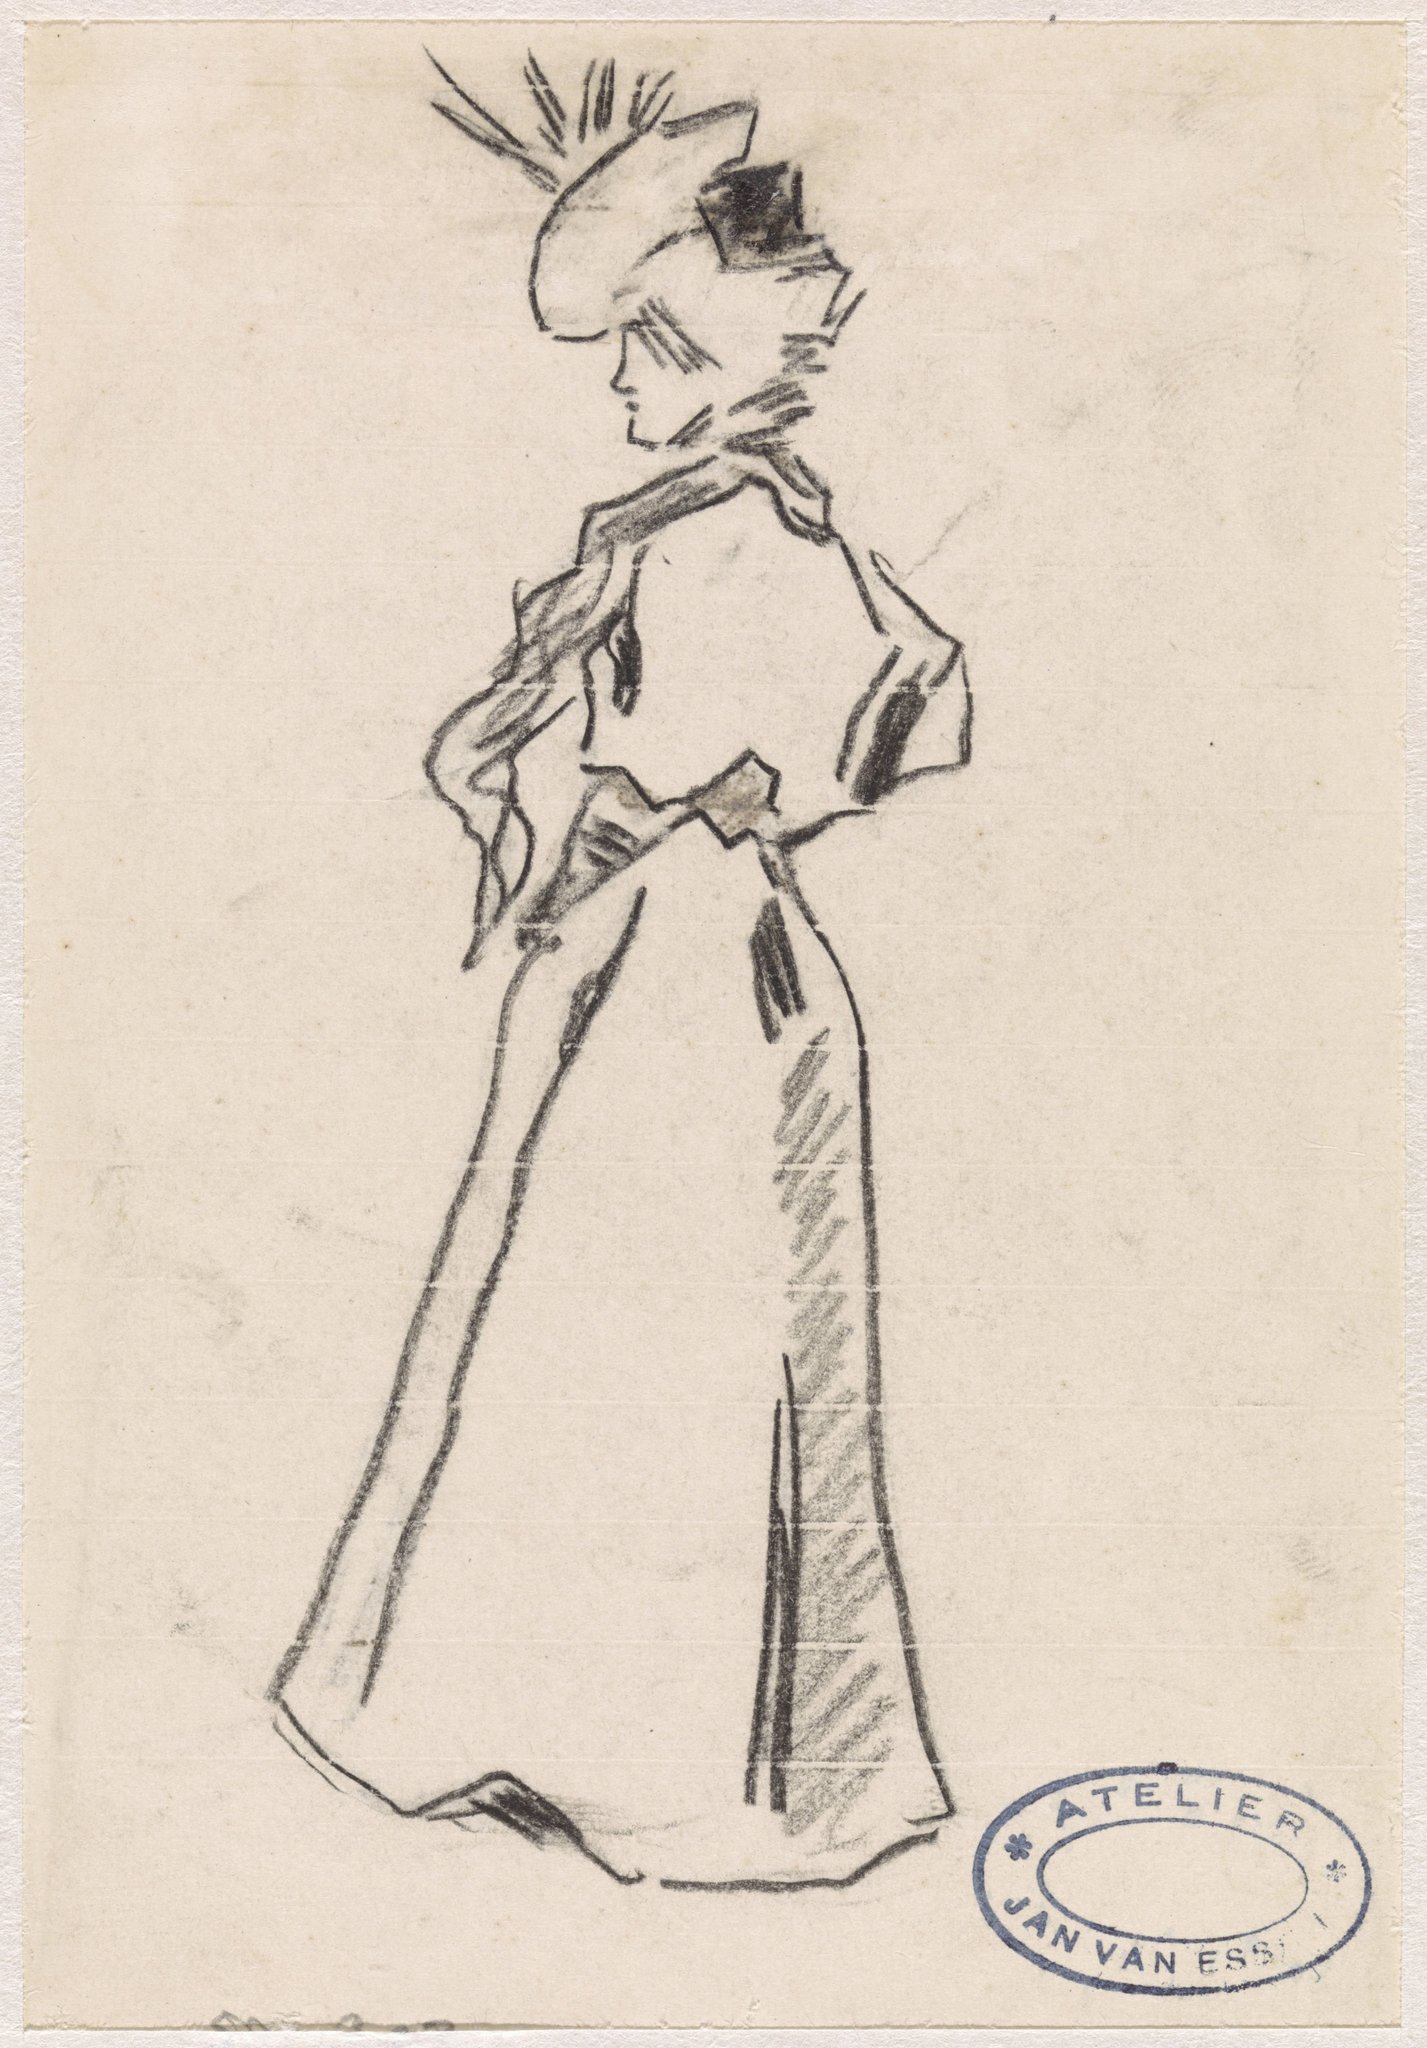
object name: drawing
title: Staande dame, met hoge hoed en de handen in de zij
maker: jan van essen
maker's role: draughtsman, print maker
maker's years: 1854-1936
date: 1864-1936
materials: chalk, paper